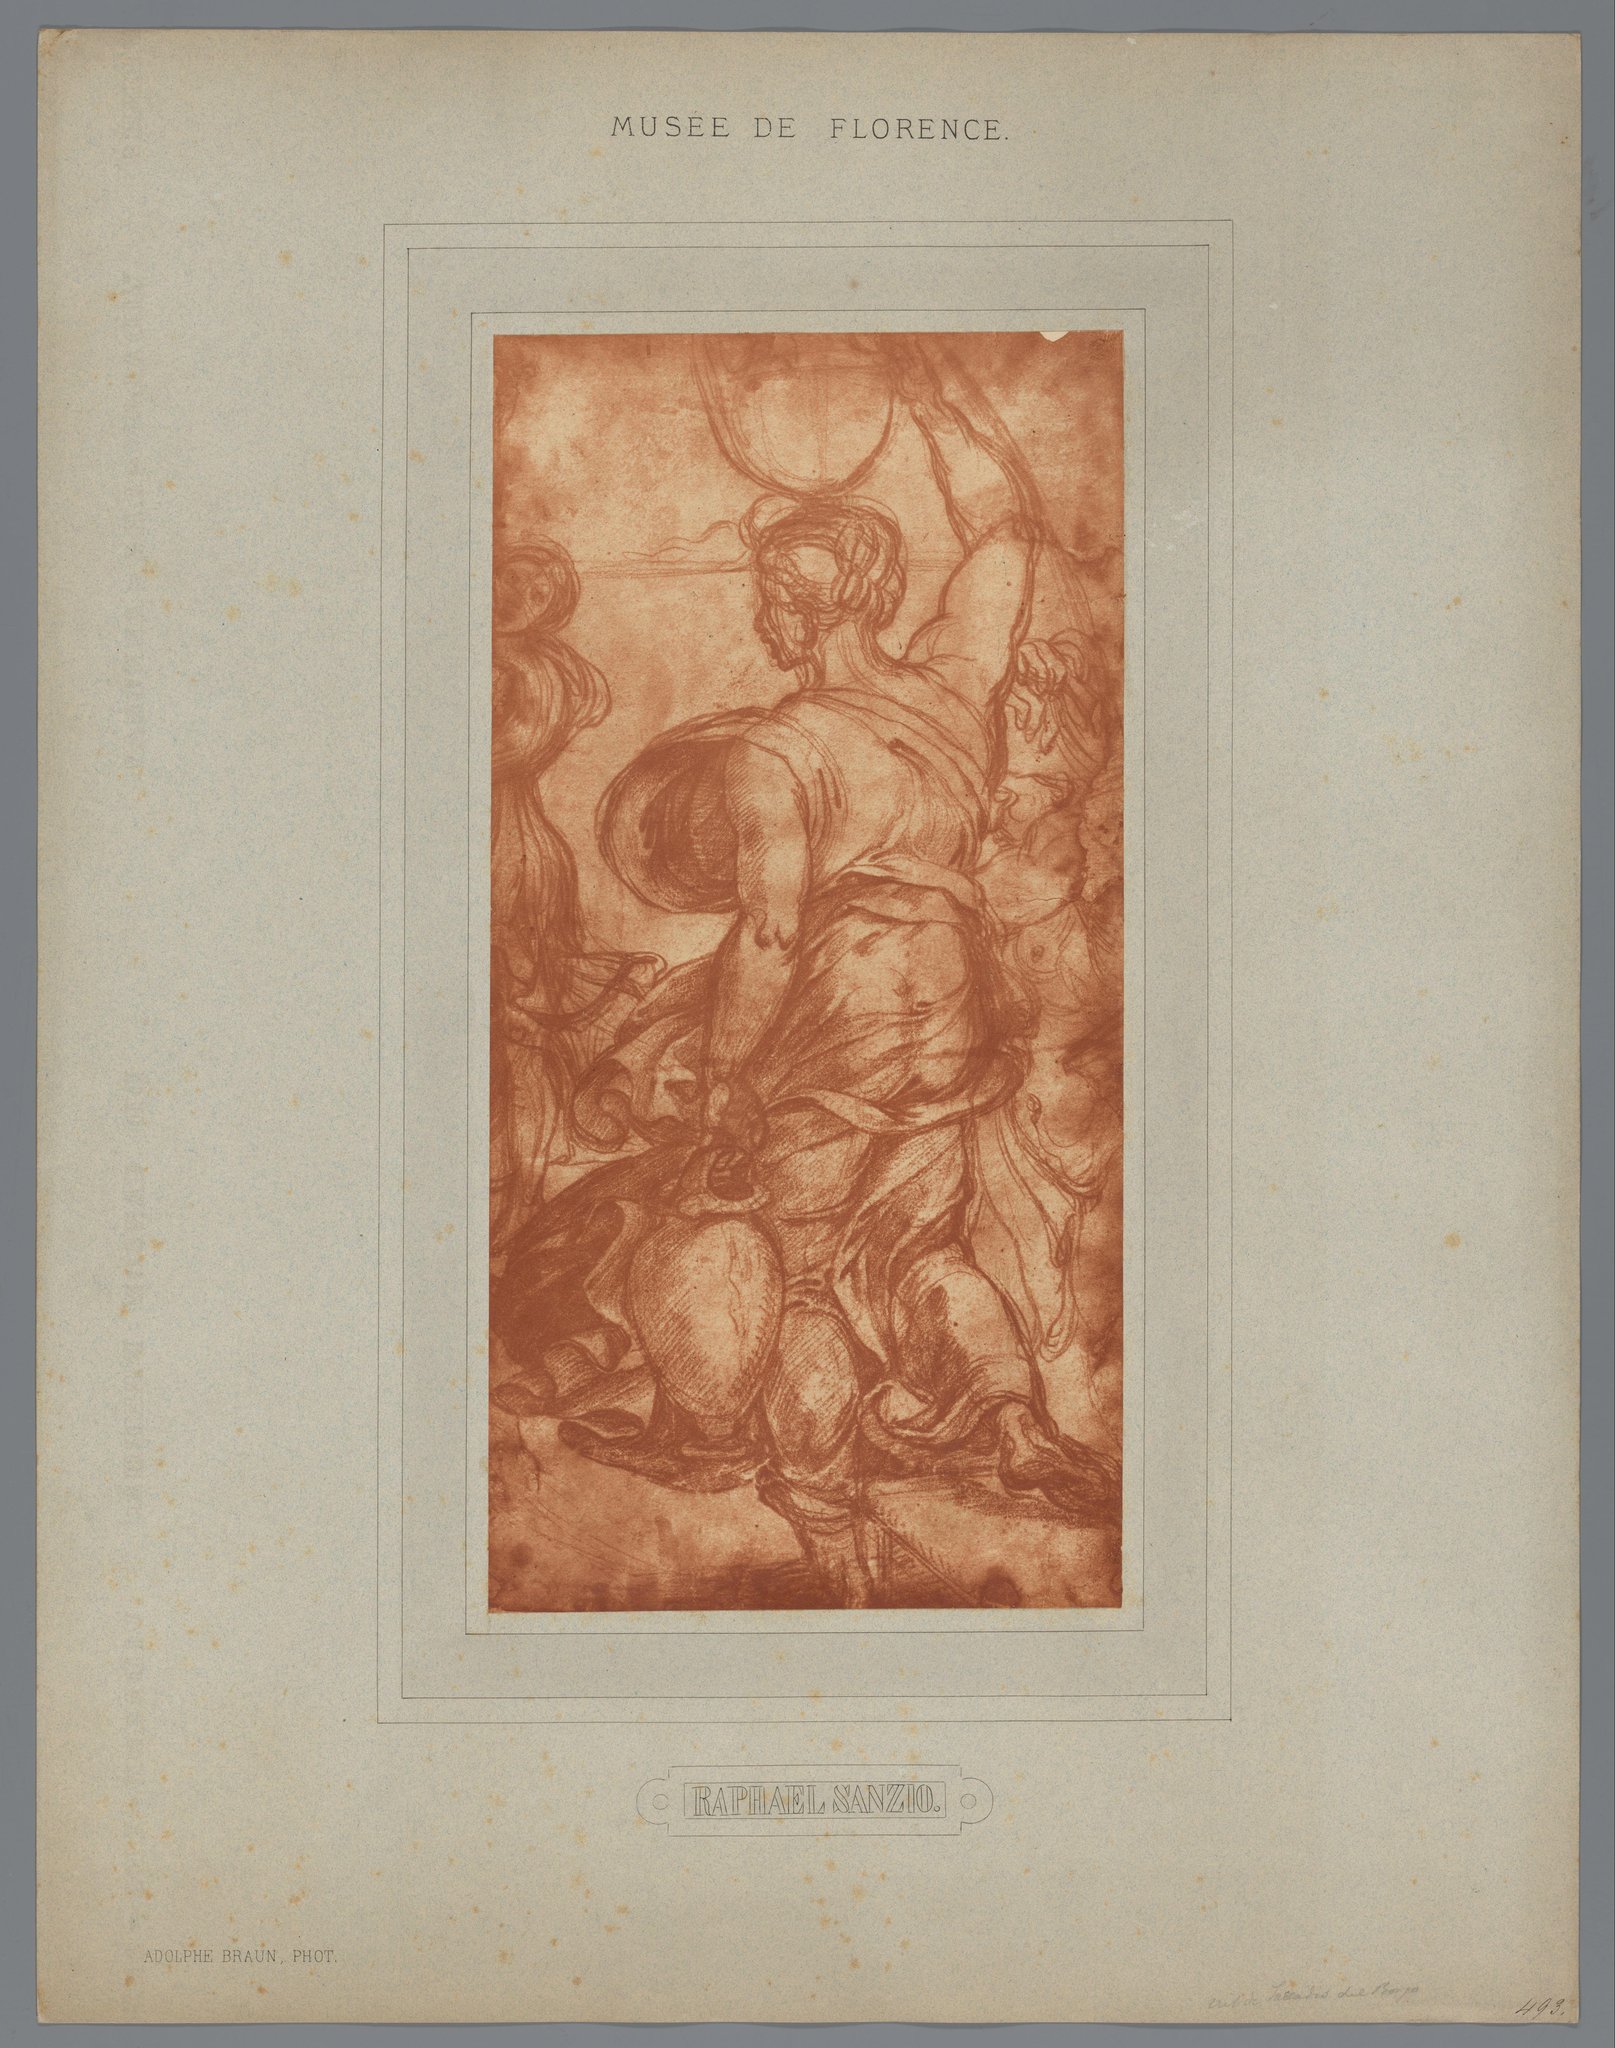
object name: photograph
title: Fotoreproductie van een tekening van Rafaël (vrouw met waterkruiken)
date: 1880-1900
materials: cardboard, paper, photographic support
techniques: carbon print